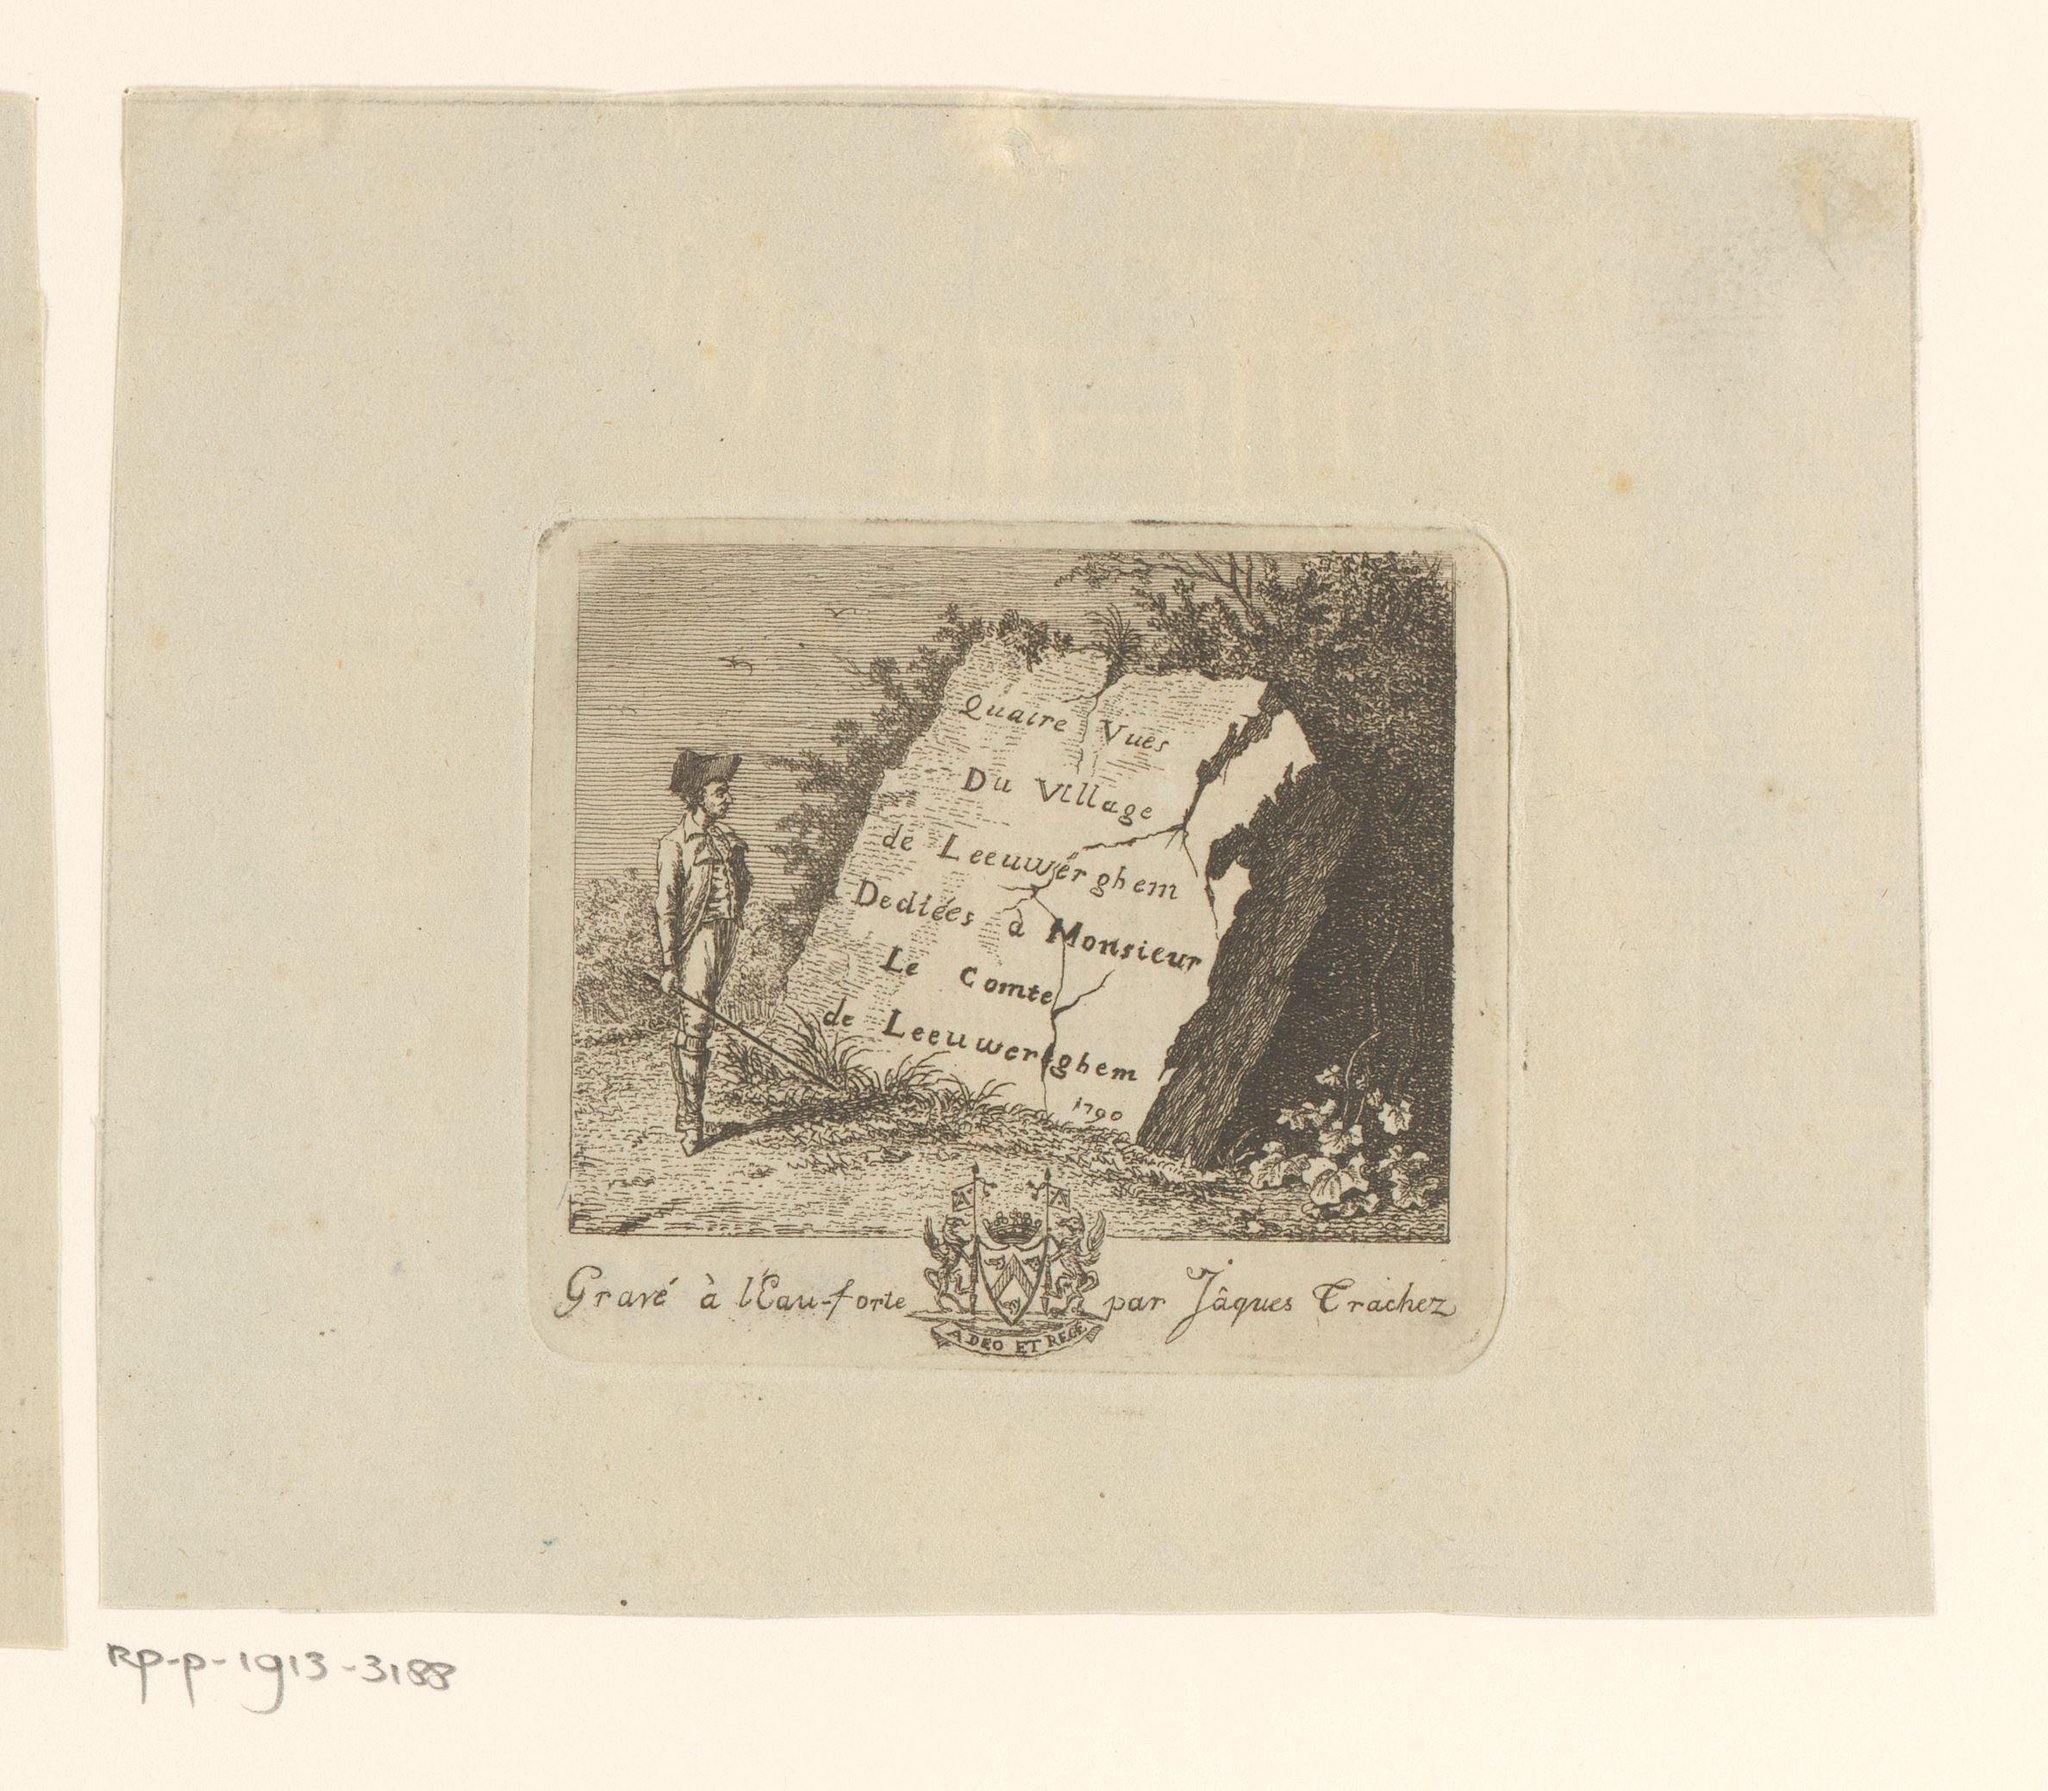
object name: titelprent, frontispice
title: Vier gezichten op het dorp Leeuwergem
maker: jacques andré joseph trachez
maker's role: print maker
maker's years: 1746-1820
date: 1790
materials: paper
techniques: etching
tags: adult man, boulder, stone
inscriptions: collector's mark: Lugt 2228